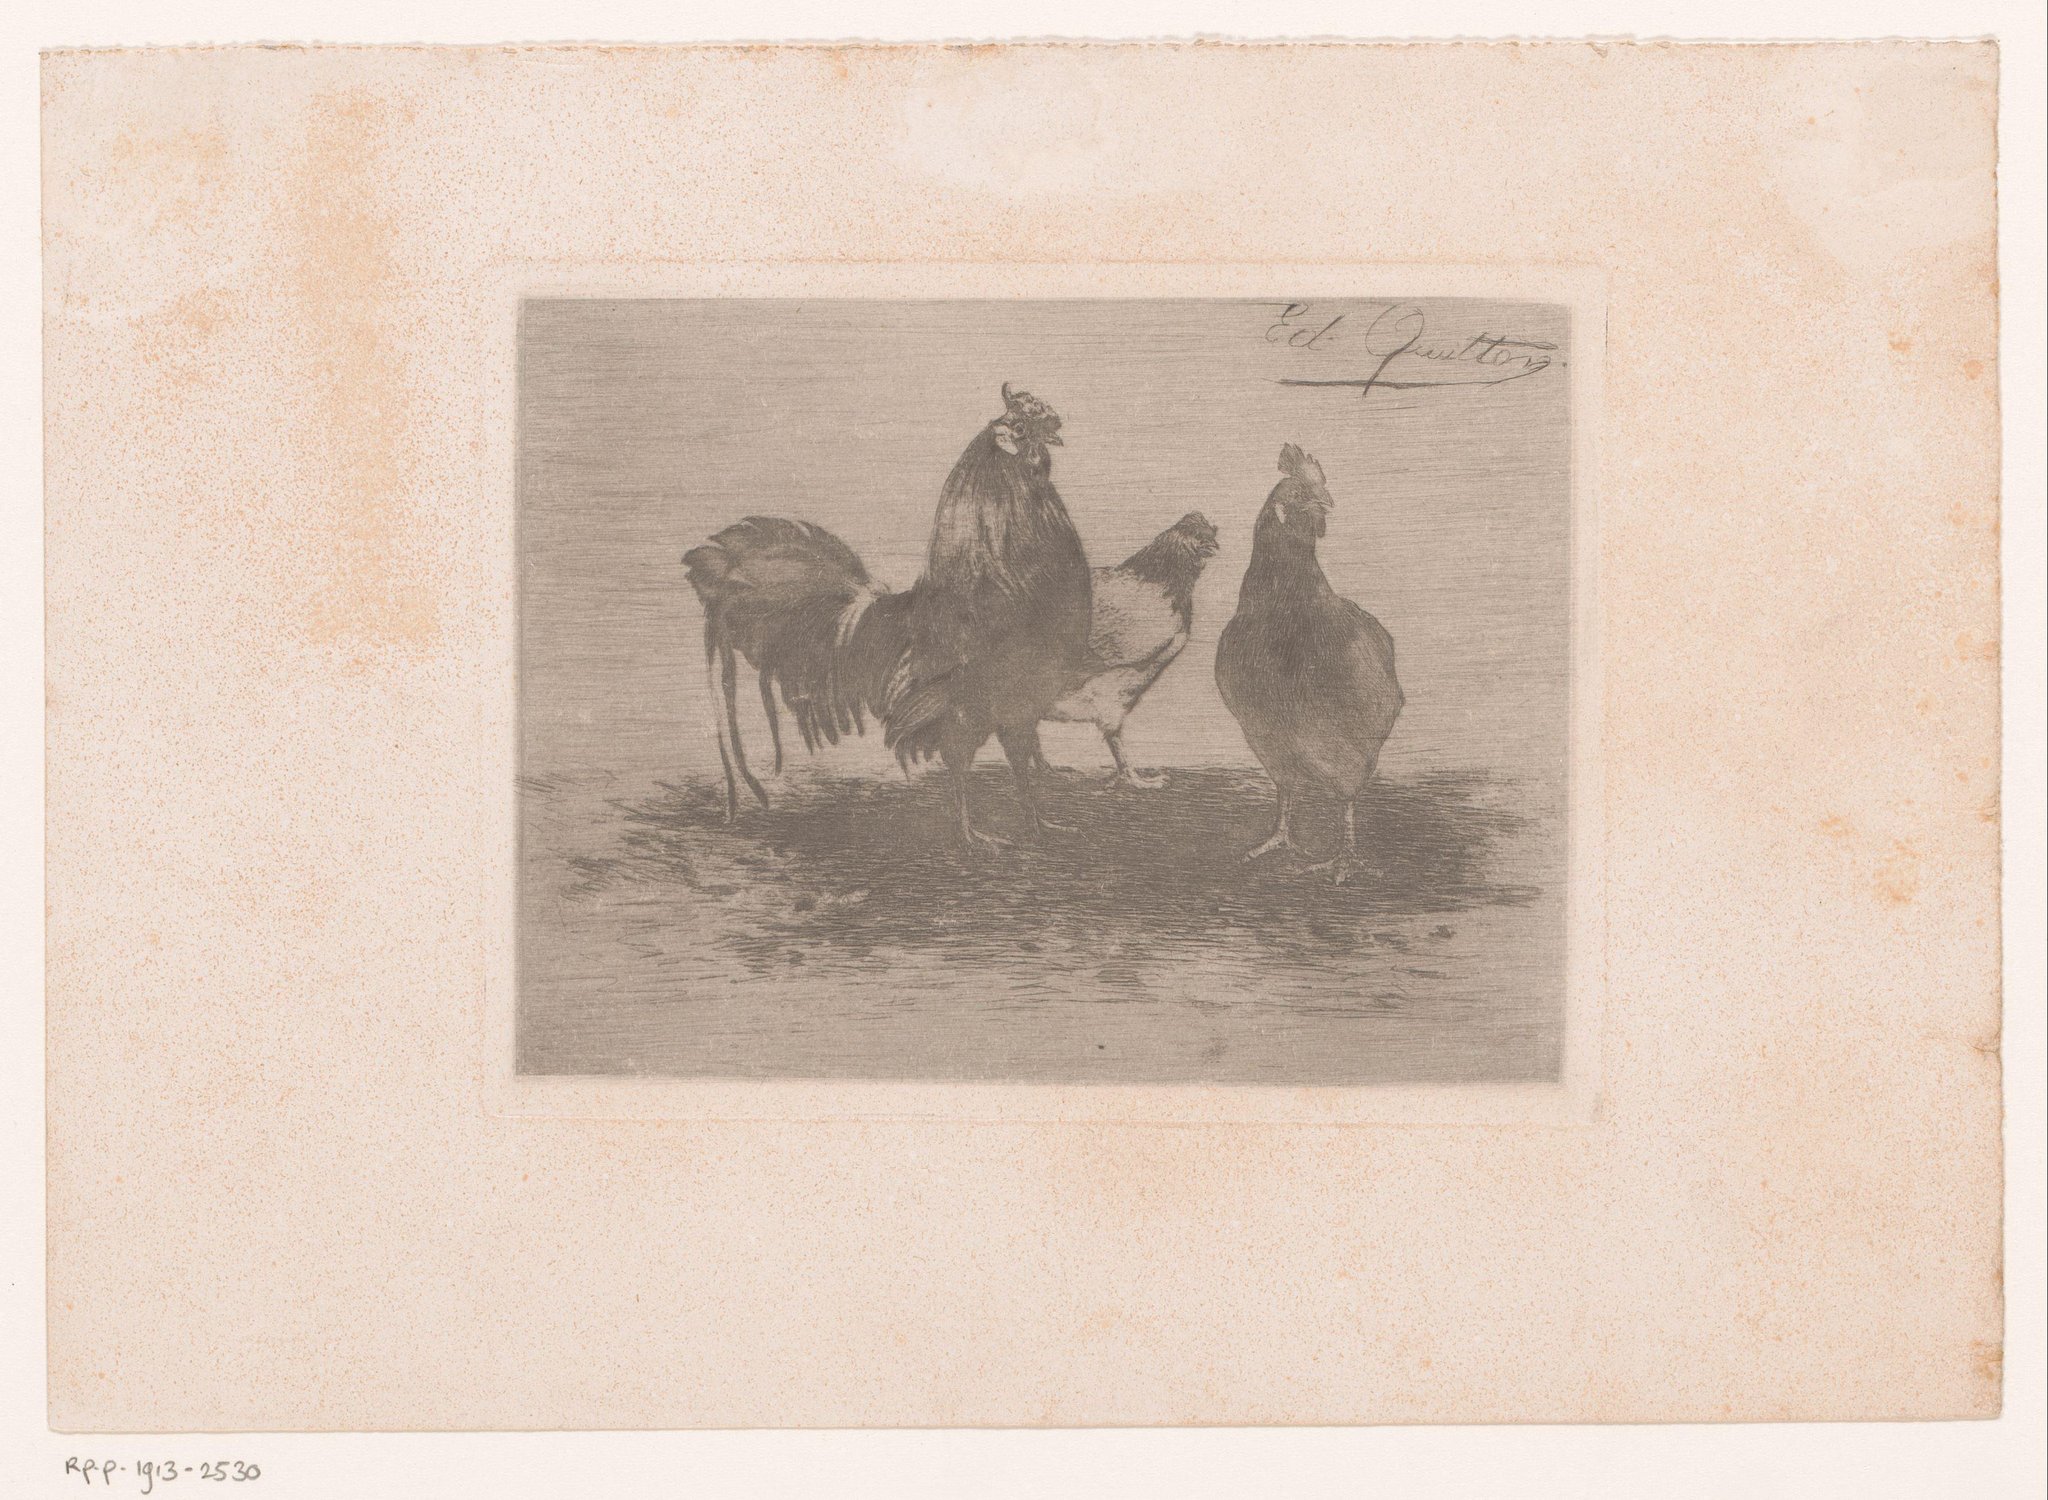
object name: print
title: Haan en twee kippen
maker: edward quitton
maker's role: print maker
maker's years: 1842-1934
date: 1852-1913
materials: paper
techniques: drypoint, etching, intaglio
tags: fowl (cock, hen, chicken, etc.)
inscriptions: collector's mark: Lugt 2228